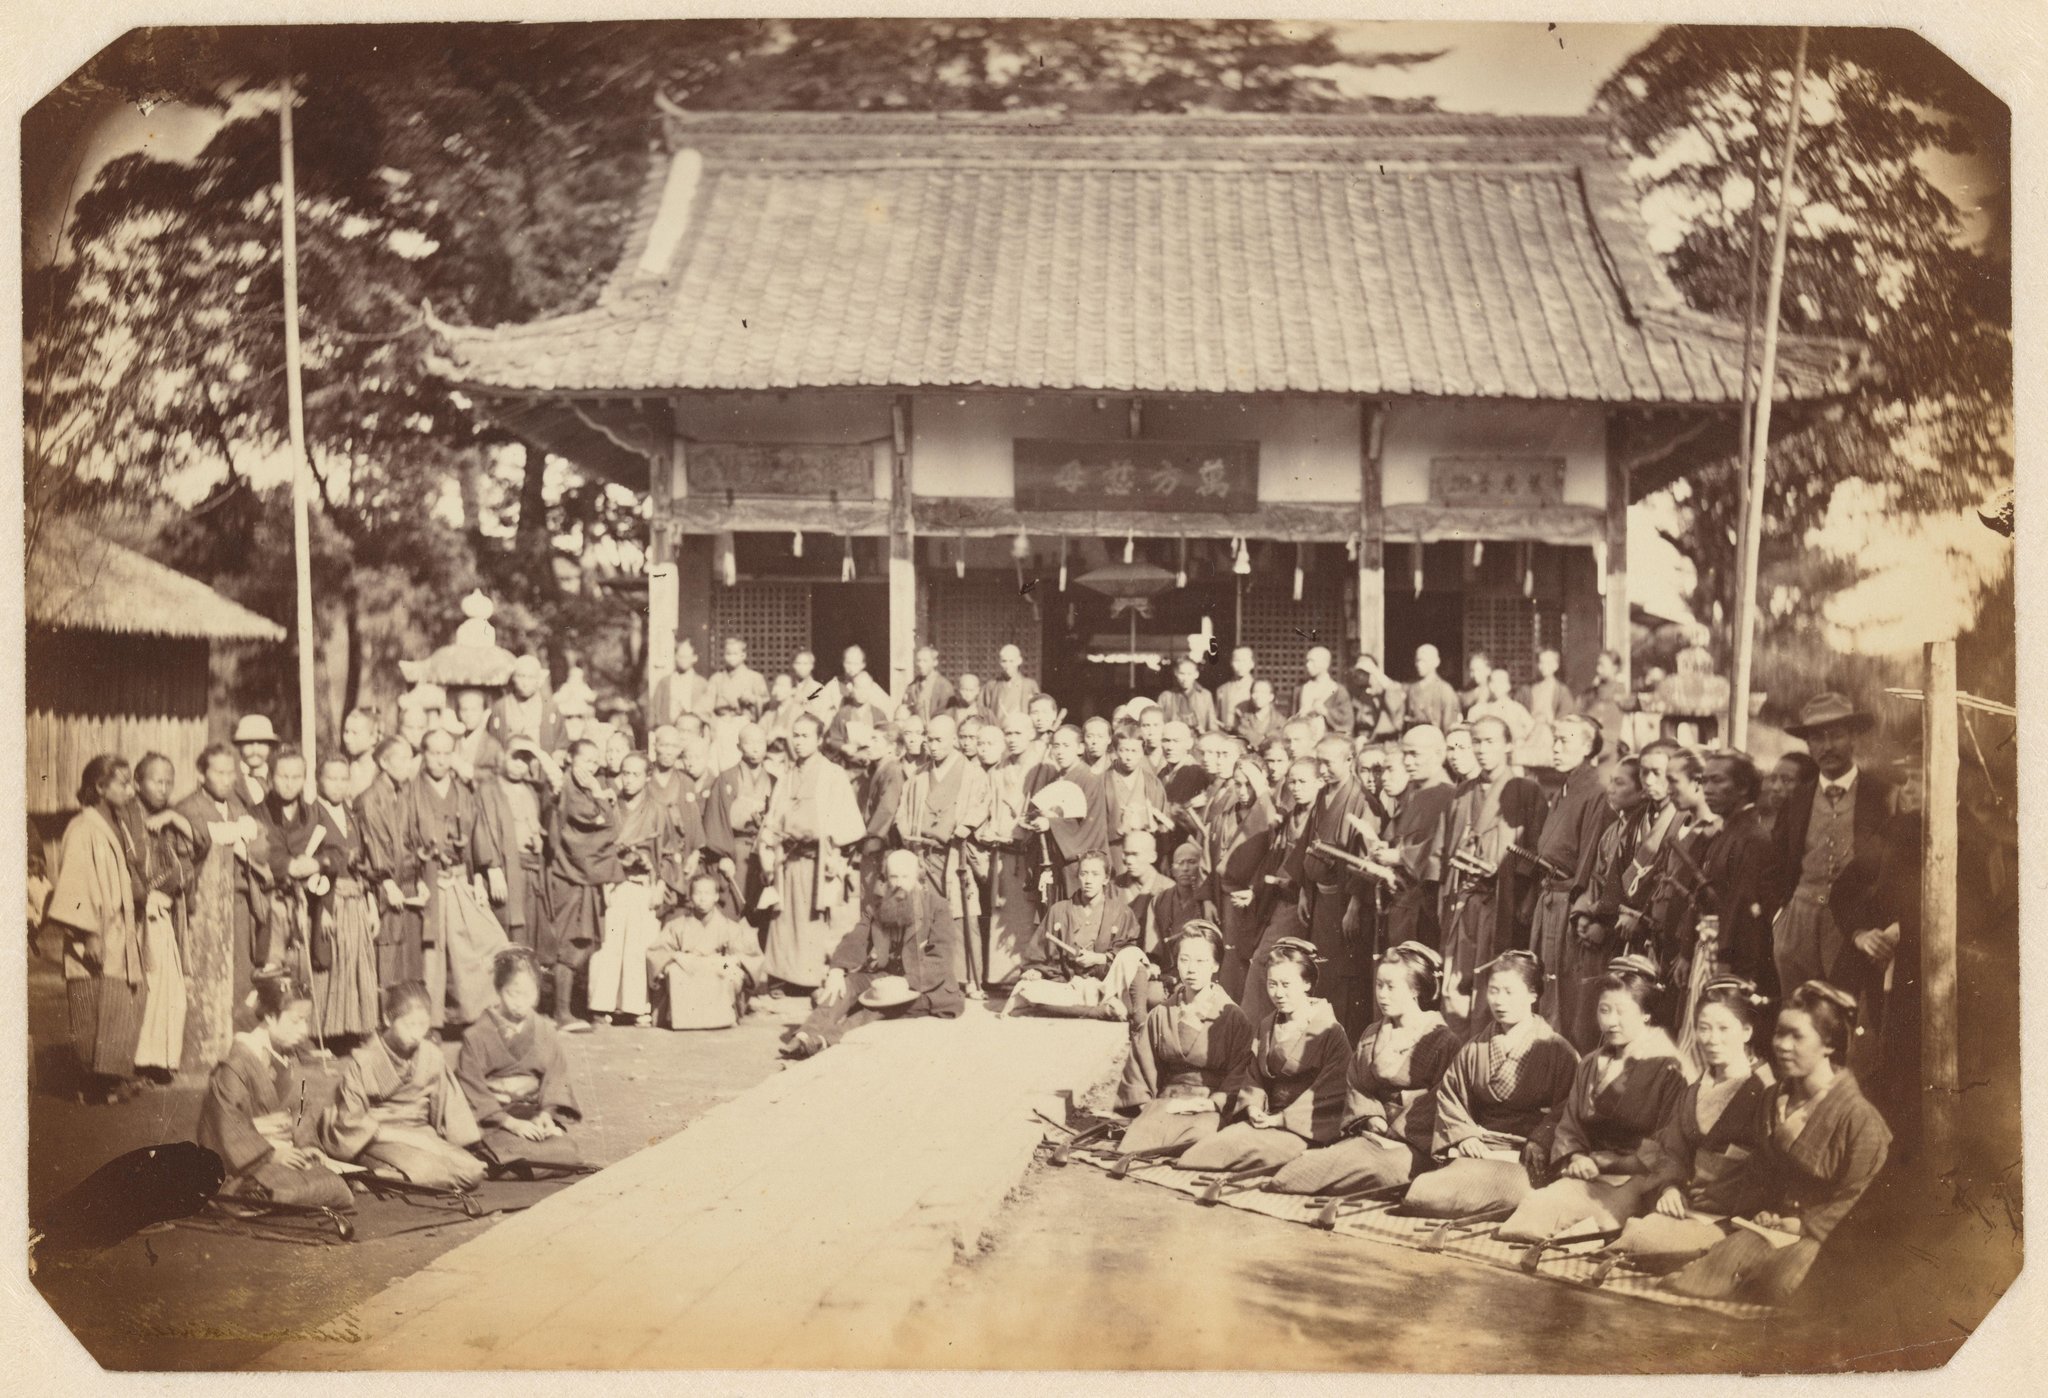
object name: photograph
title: Hospital farewell party in Nagasaki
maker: Anonymous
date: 1867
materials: paper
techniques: albumen print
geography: japan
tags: nagasaki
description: Antoon Bauduin’s predecessors in Japan, J.K. de Wit and J. Pompe van Meerdervoort, taught photography as part of their duties. This was not required of Bauduin, so he took photographs purely for his own enjoyment. He further pared down his teaching duties by focusing solely on medicine and leaving the chemistry and physics instruction to colleagues.